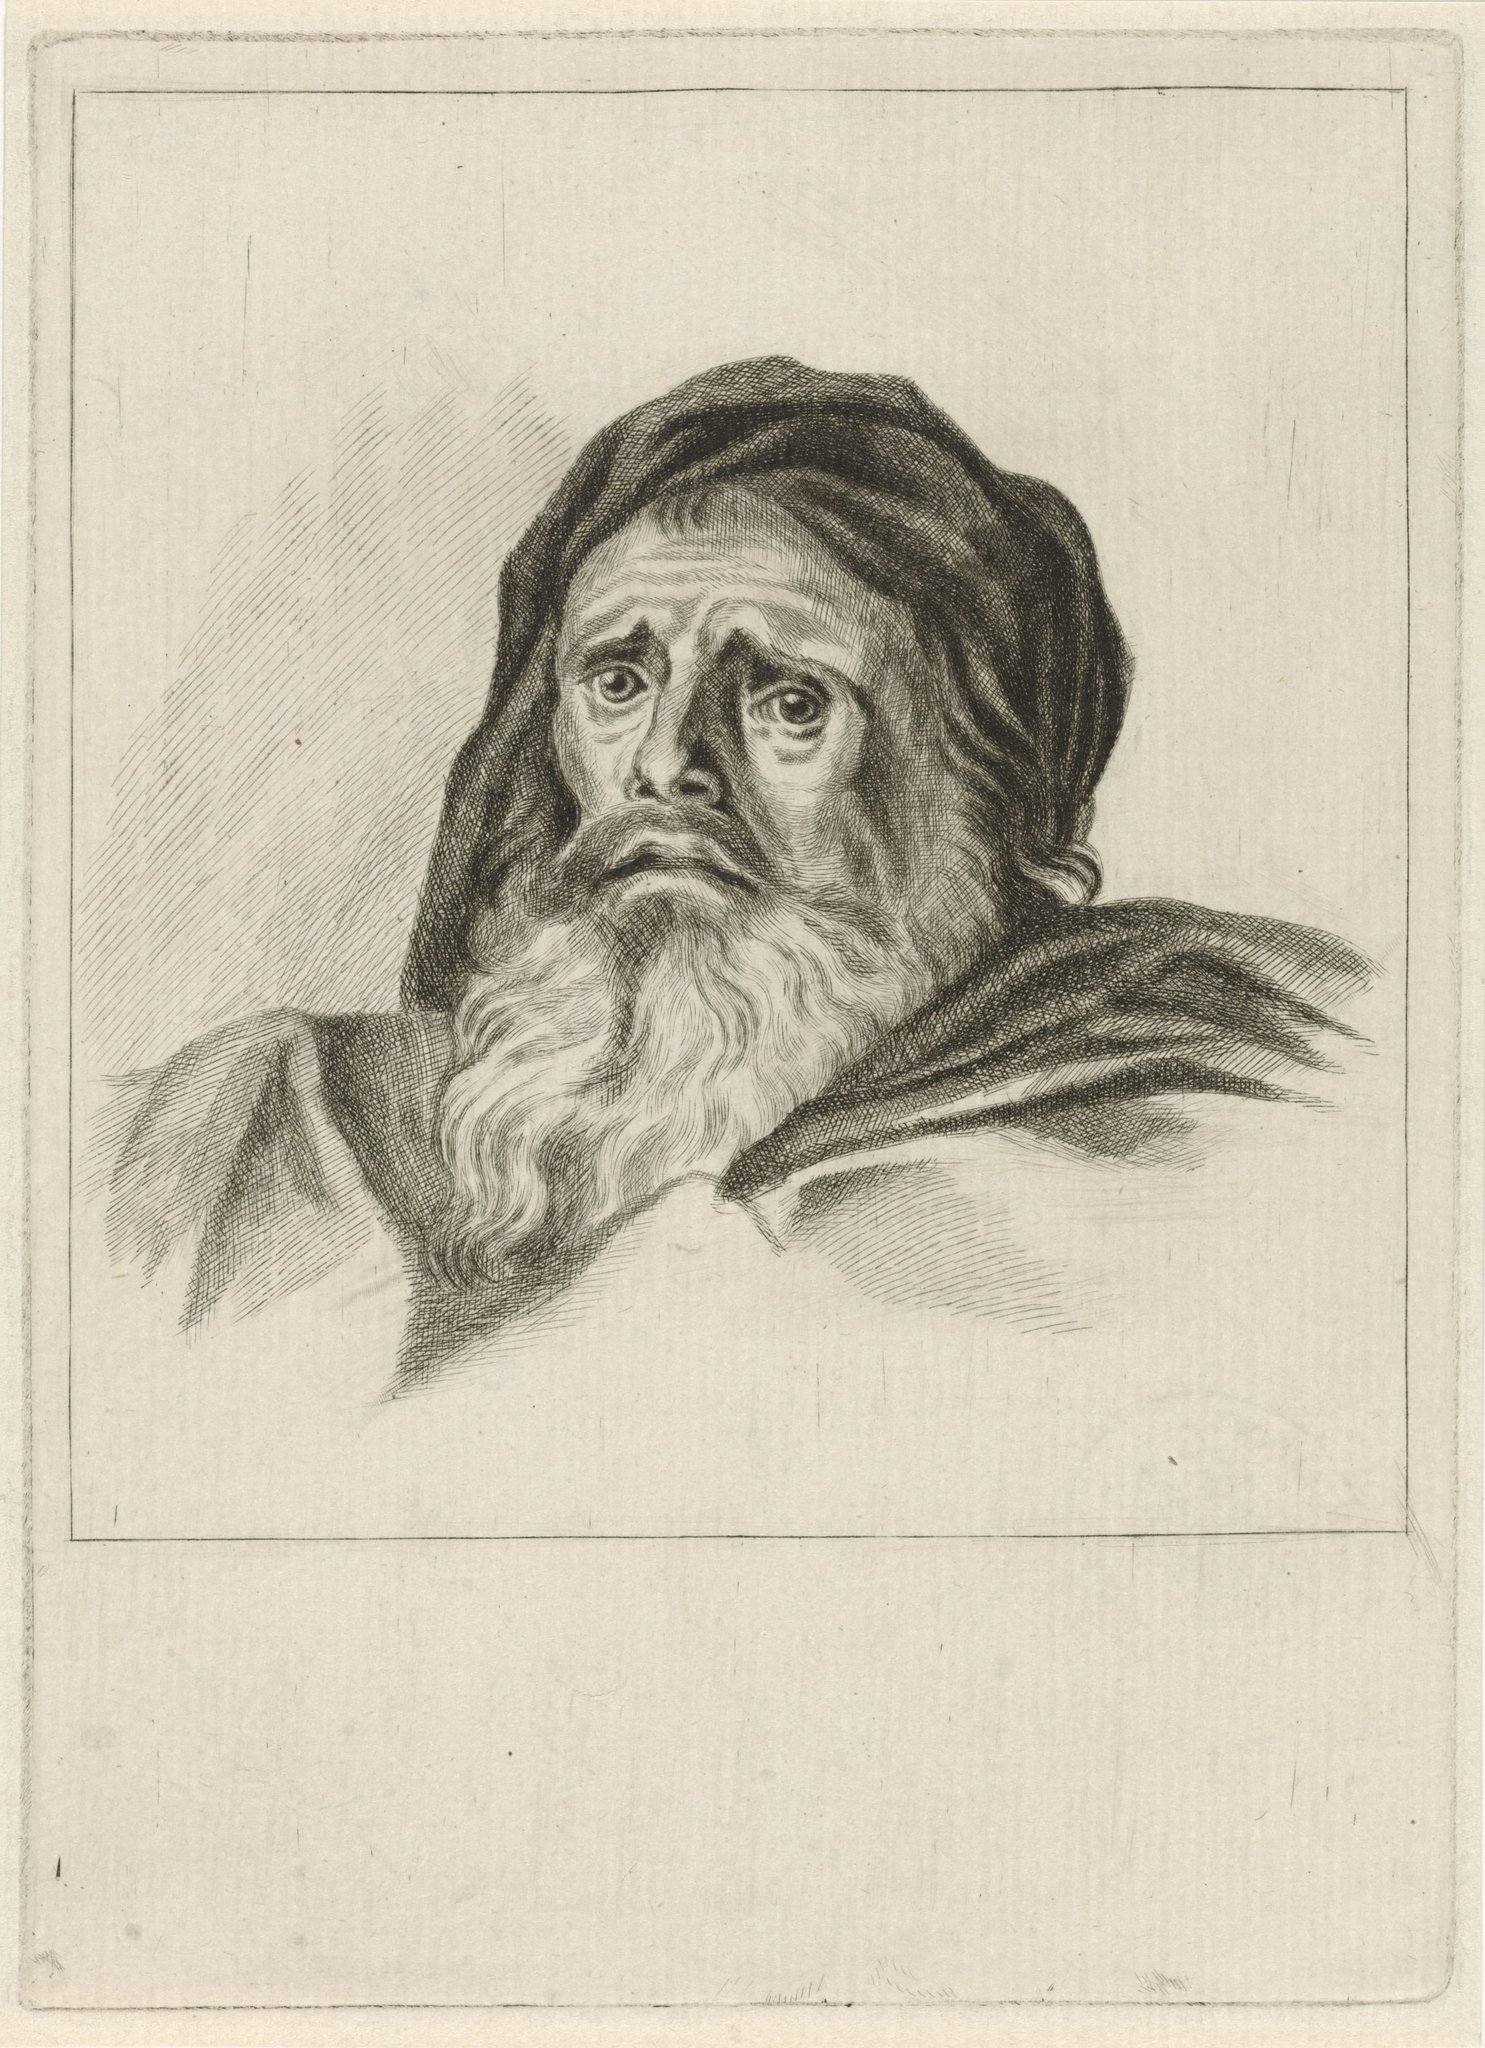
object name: print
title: Kop van een man met baard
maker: pieter de mare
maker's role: print maker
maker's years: 1758-1796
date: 1768-1796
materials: paper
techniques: engraving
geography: leiden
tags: head (human), head-gear: cap (+ men's clothes), beard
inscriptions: collector's mark: Lugt 240